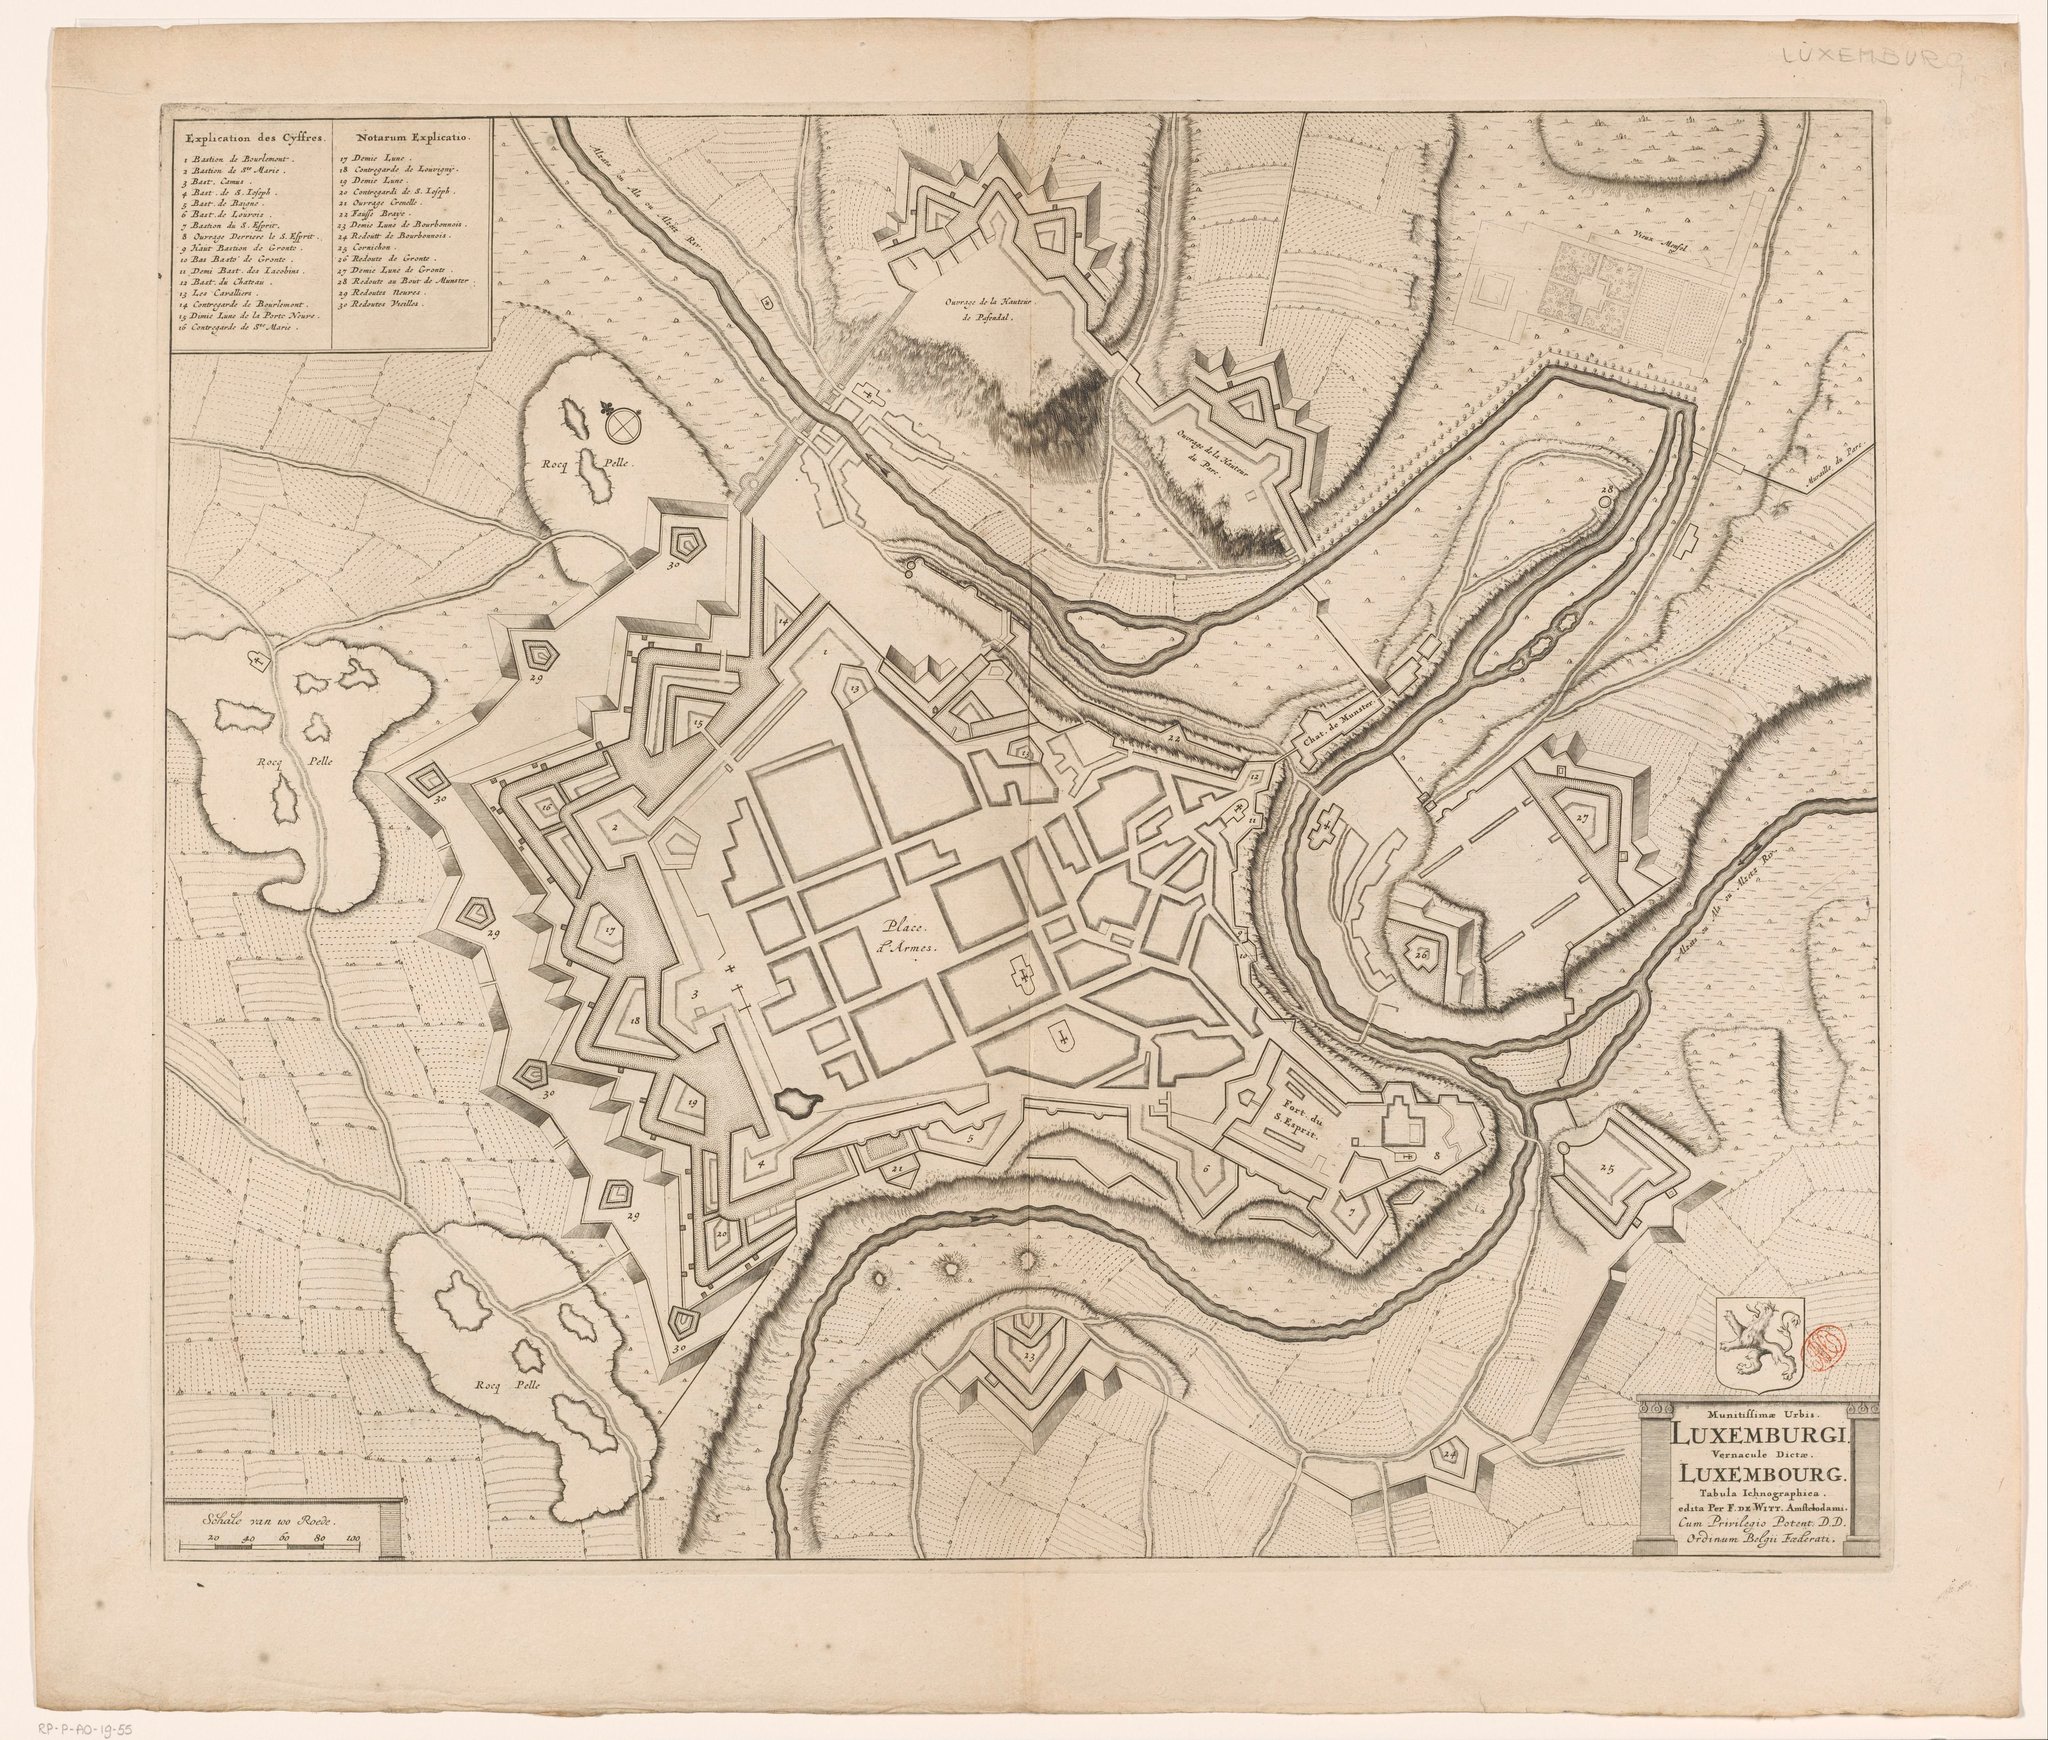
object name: print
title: Munitissimae urbis Luxemburgi vernacule dictae Luxembourg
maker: Anonymous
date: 1698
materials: paper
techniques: engraving, etching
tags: coat of arms (as symbol of the state, etc.) (+ city; municipal), fortified city, maps of cities, coat of arms (as symbol of the state, etc.) (+ province; provincial)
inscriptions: collector's mark: Lugt 195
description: Prent ook gebruikt in: Theatrum ichnographicum omnium urbium et praecipuorum oppidorum Belgicarum XVII Provinciarum (…). Amsterdam: Frederik de Wit, ca. 1700-1710. En in: Aa, Pieter van der. La galerie agreable du monde (…). 66 delen. Leiden: Pieter van der Aa, 1728, dl. 15.